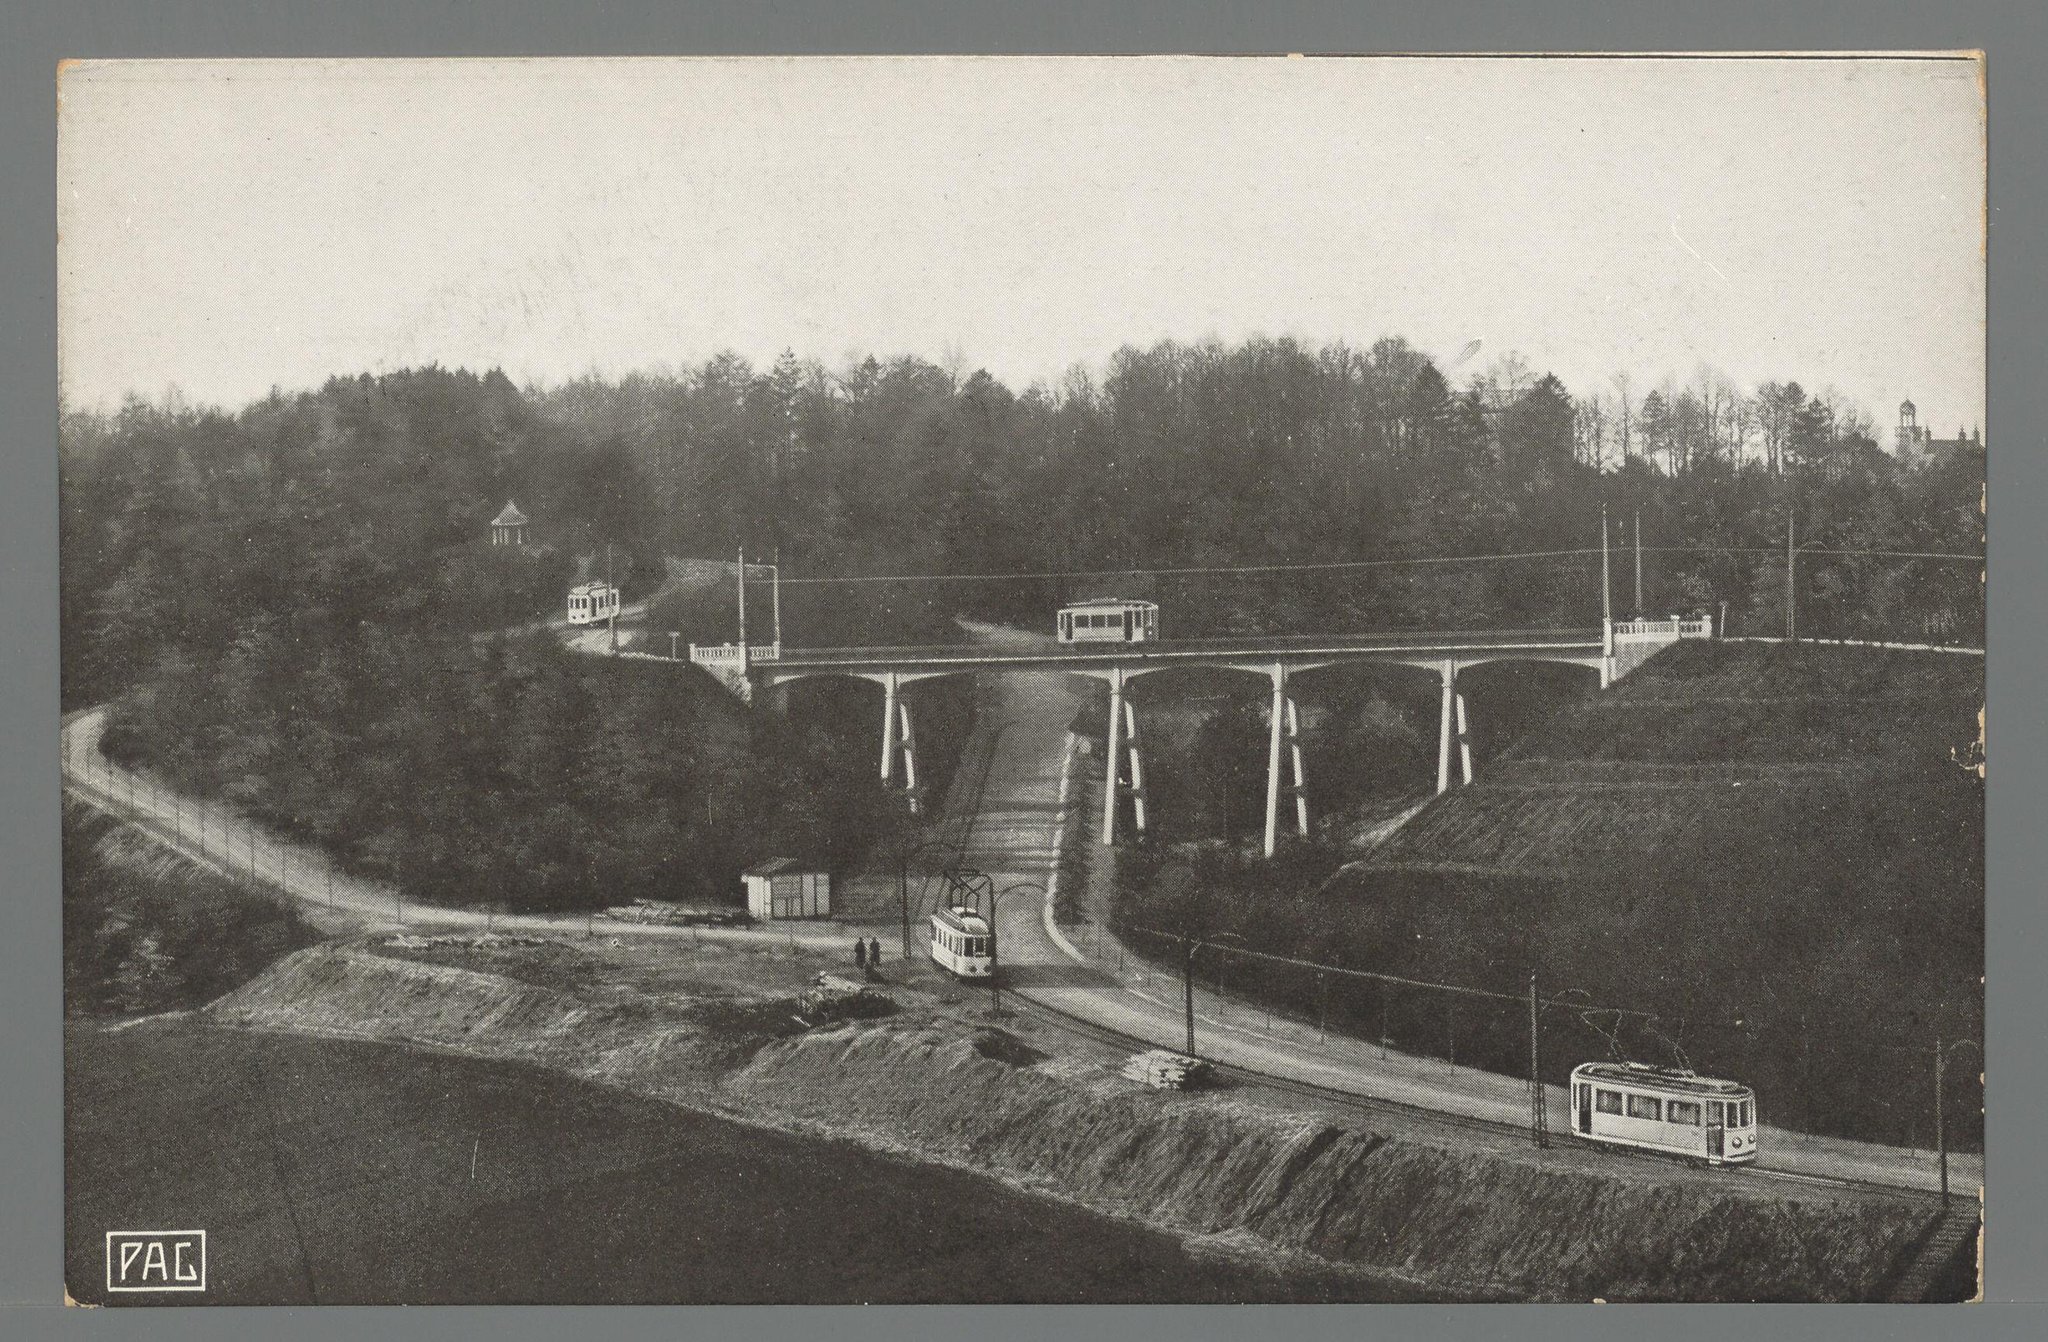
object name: photomechanical print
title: Trambrug van den Musschenberg gezien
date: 1905-1930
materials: cardboard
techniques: autotype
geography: berg en dal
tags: tram, tramway, tram